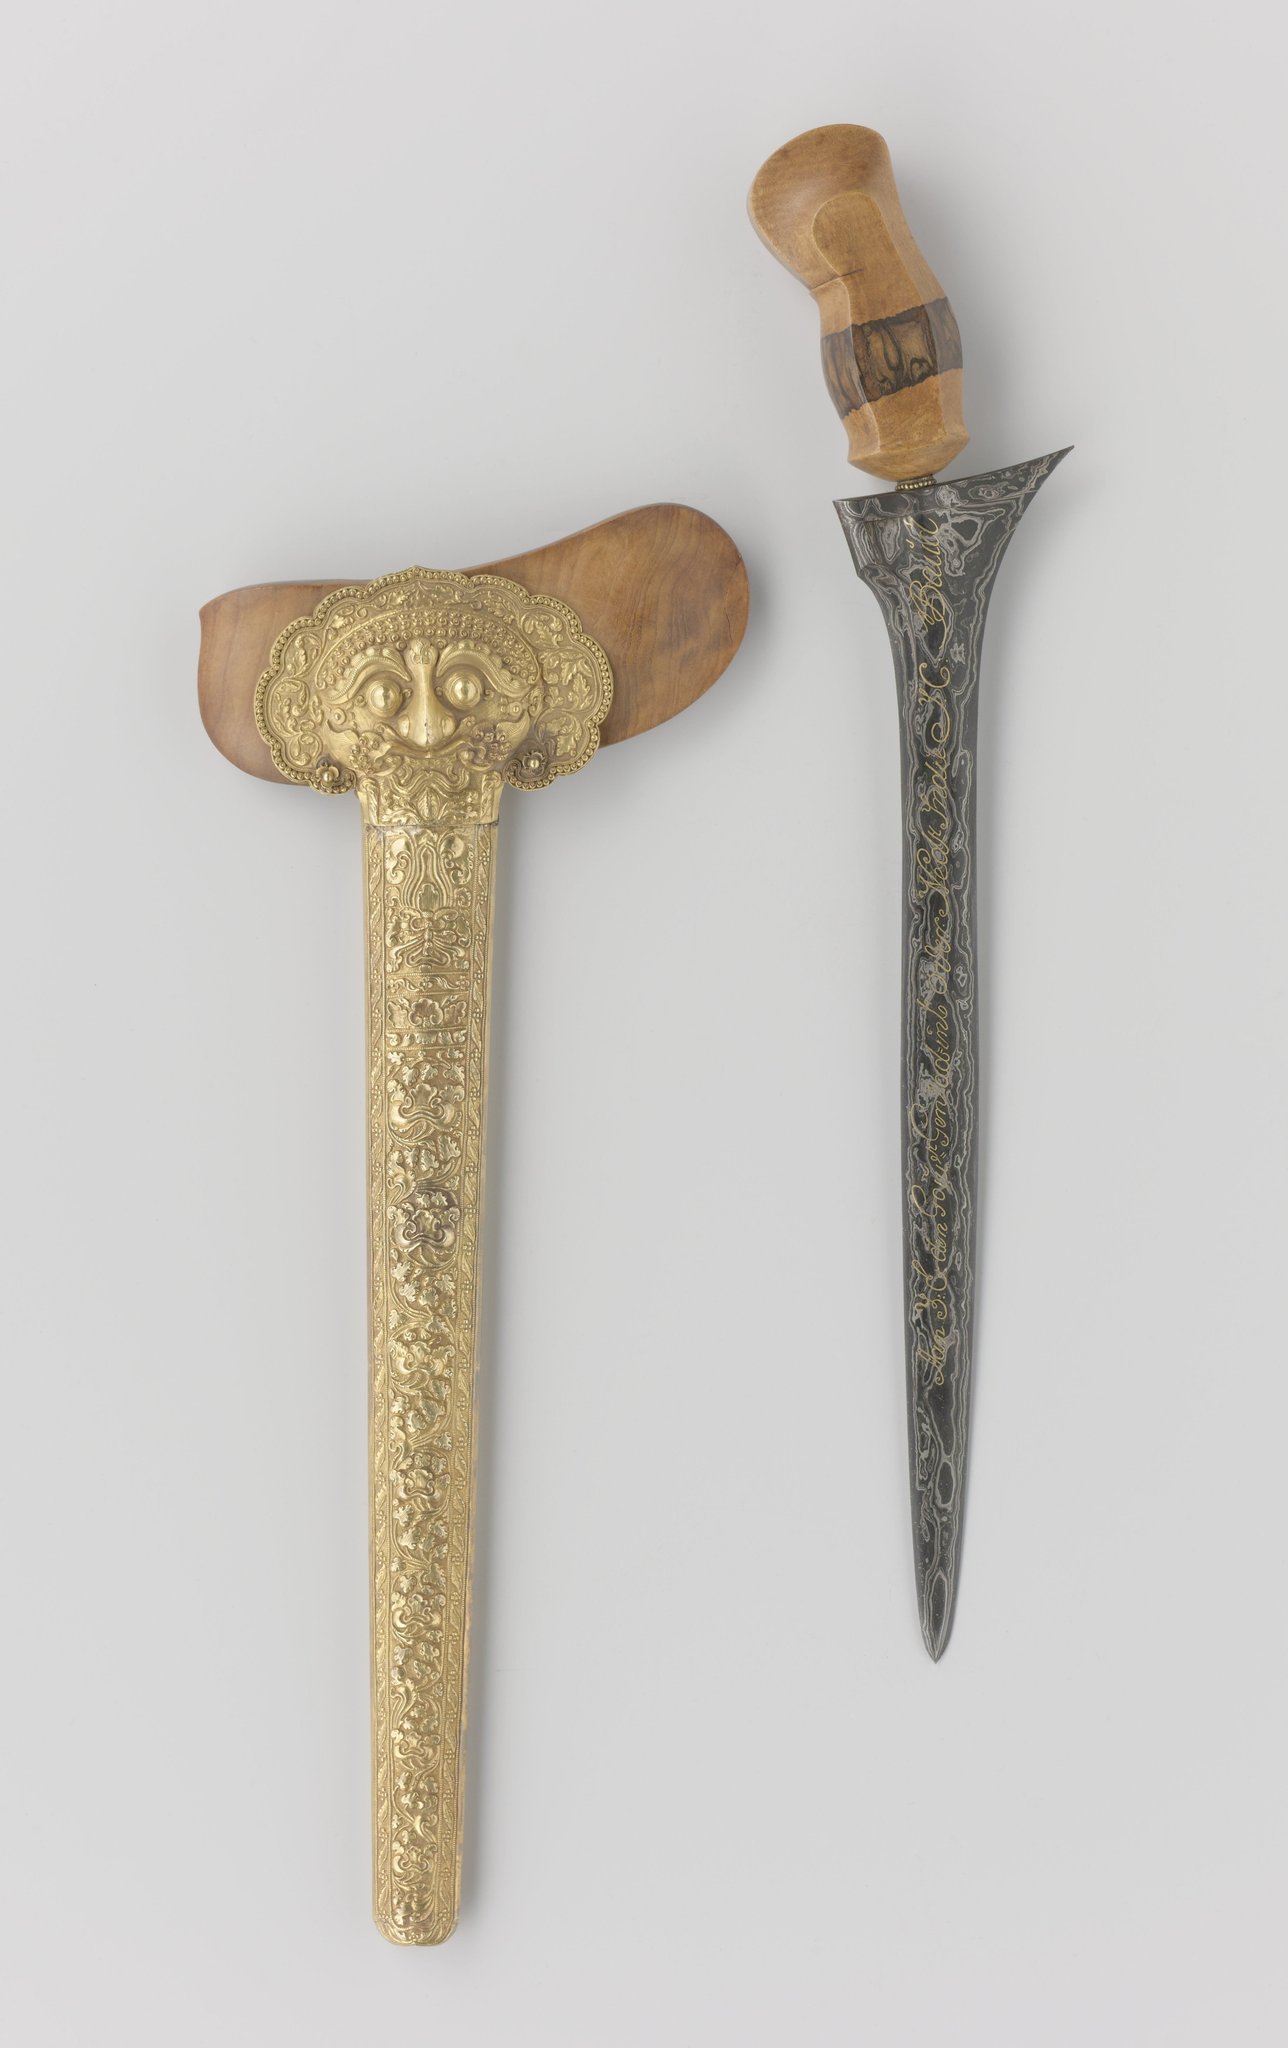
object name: kris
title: Kris of Governor-General Baud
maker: Anonymous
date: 1834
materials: gold, iron, nickel, wood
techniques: forging, inlay, carving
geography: madura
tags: the hague, dutch east indies, the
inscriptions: inscription: ‘Den Pan=m Van Panakassan Mangkoc Adie Ningrat/7e Junuarij+1834’, inscription: ‘Aan Z:E den Gouv=er Gen=ad=int over. Ned=r Indie J:C:Baud’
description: J.C. Baud, Governor-General of the Dutch East Indies, was presented with this kris by Mangkoe Adie Ningrat, ruler of Pamekasan, during his inspection tour on Java and Madura in 1834. The exchange of gifts between native rulers and Dutch officials was important in maintaining good diplomatic relations. A kris, as a symbol of power that protected its wearer against evil, was a highly appropriate gift.